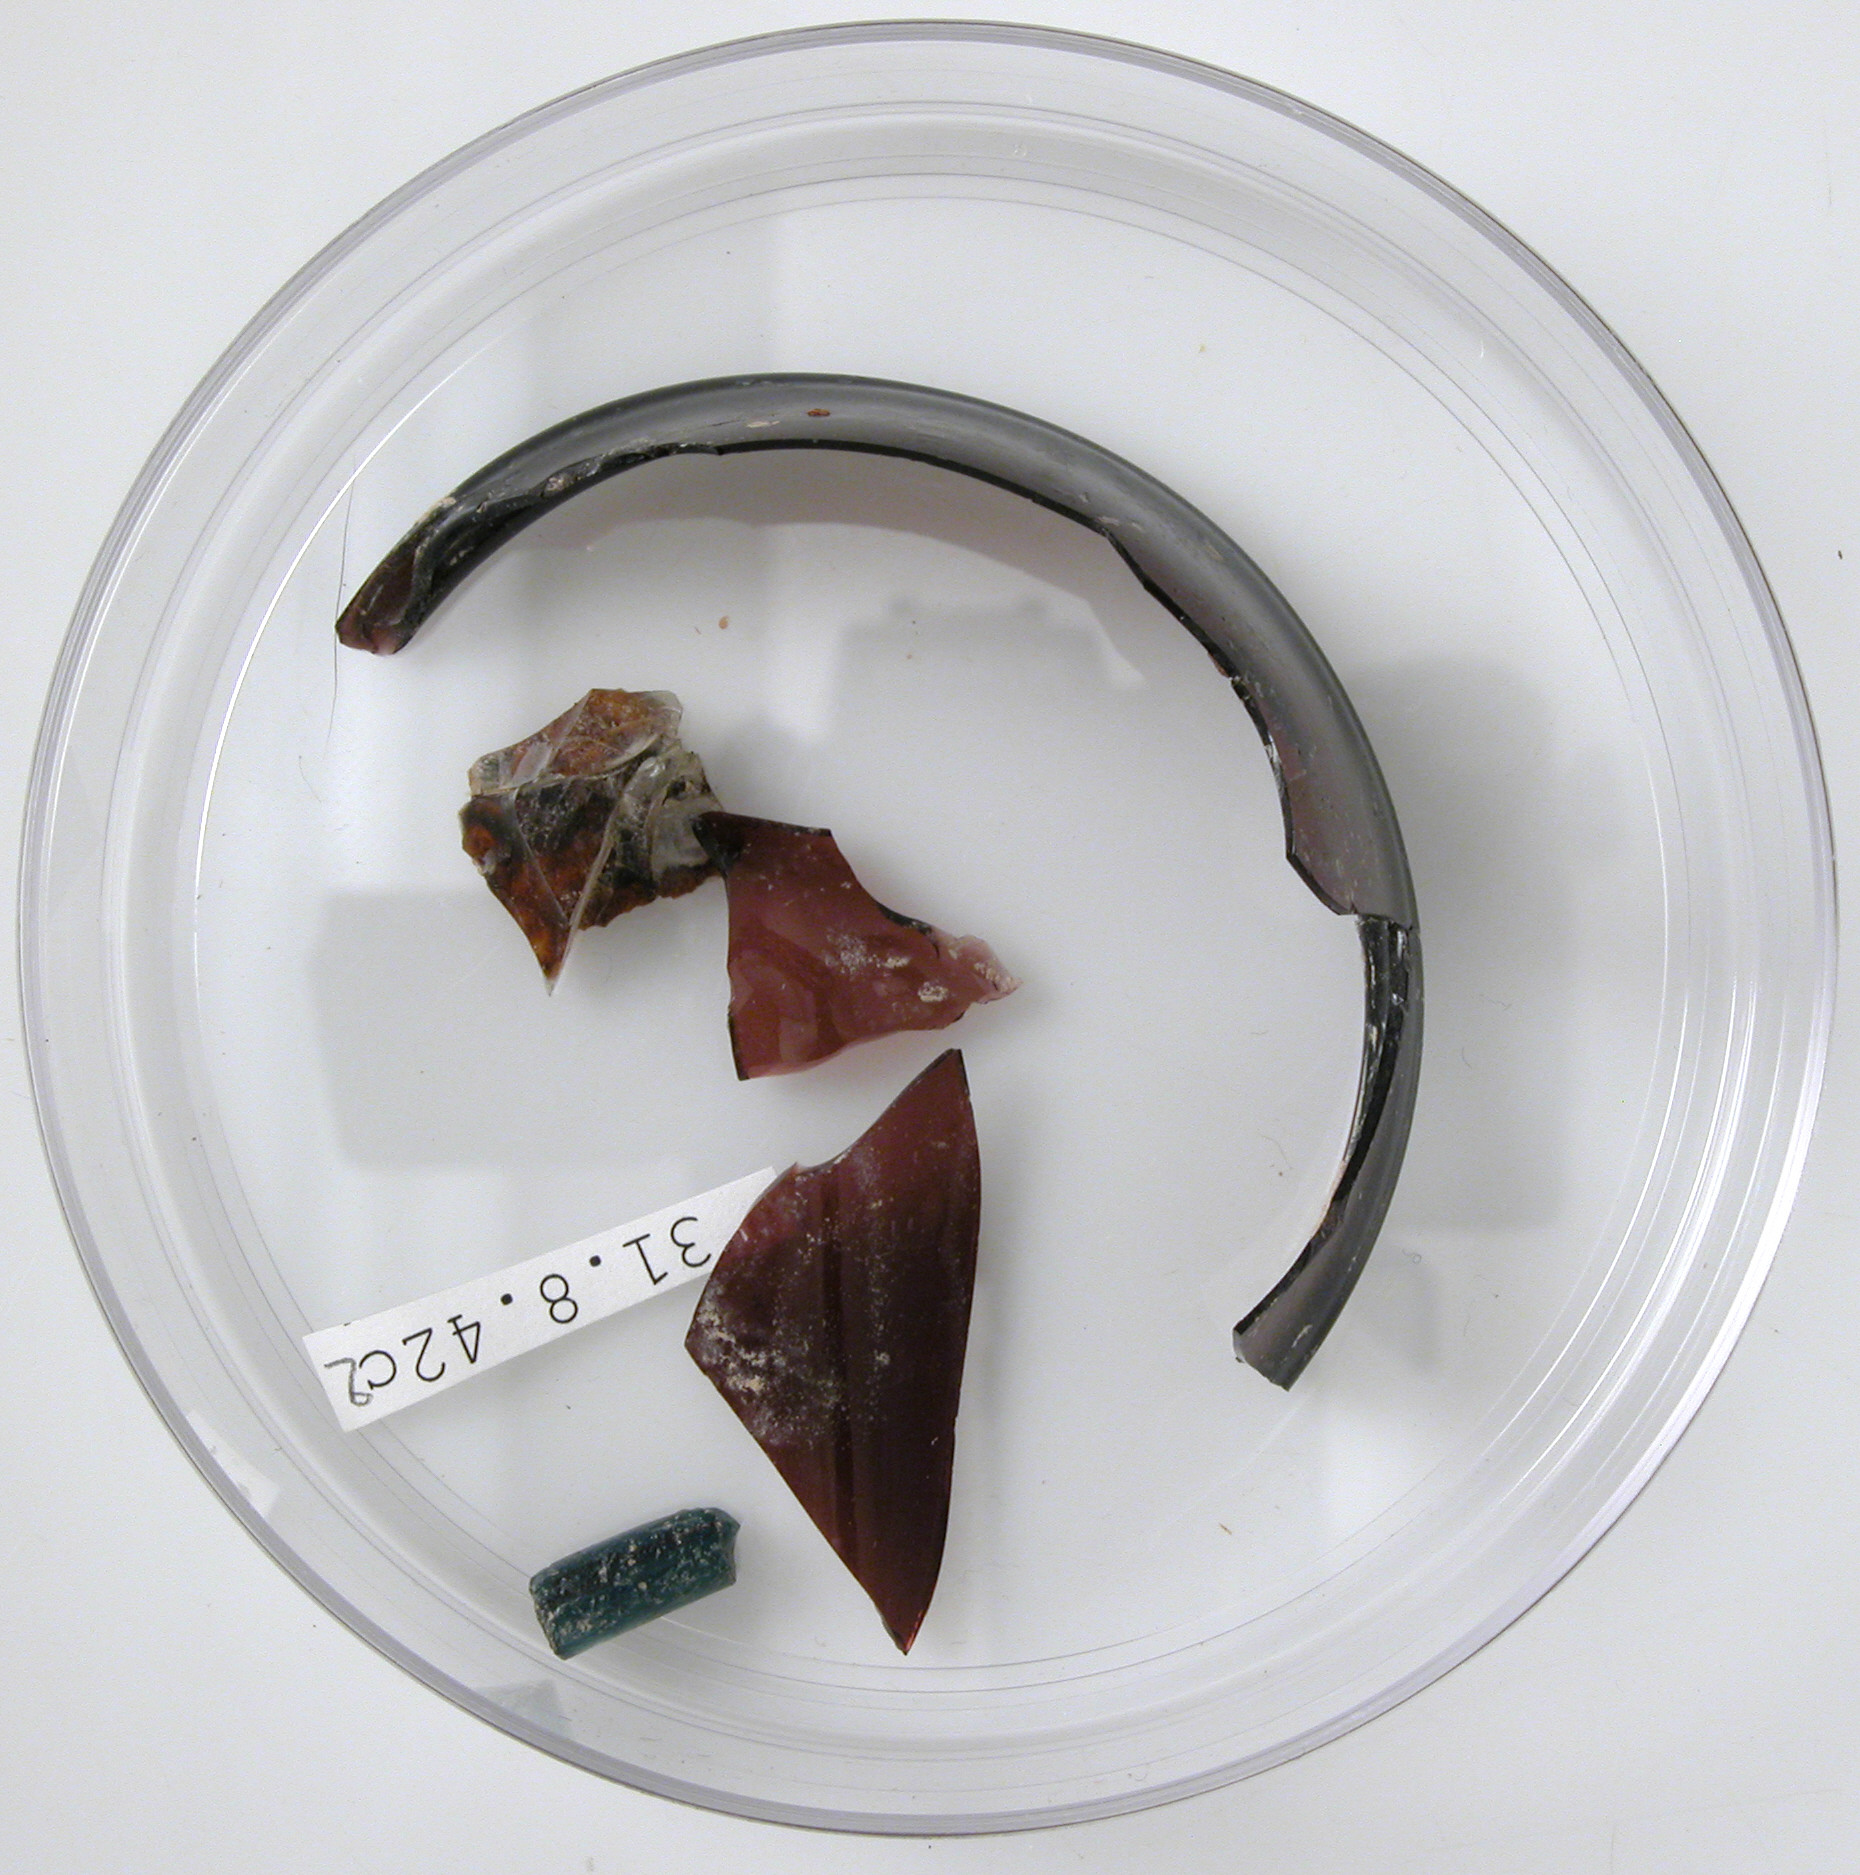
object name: fragment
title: Glass Fragments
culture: coptic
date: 301-400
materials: glass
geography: egypt